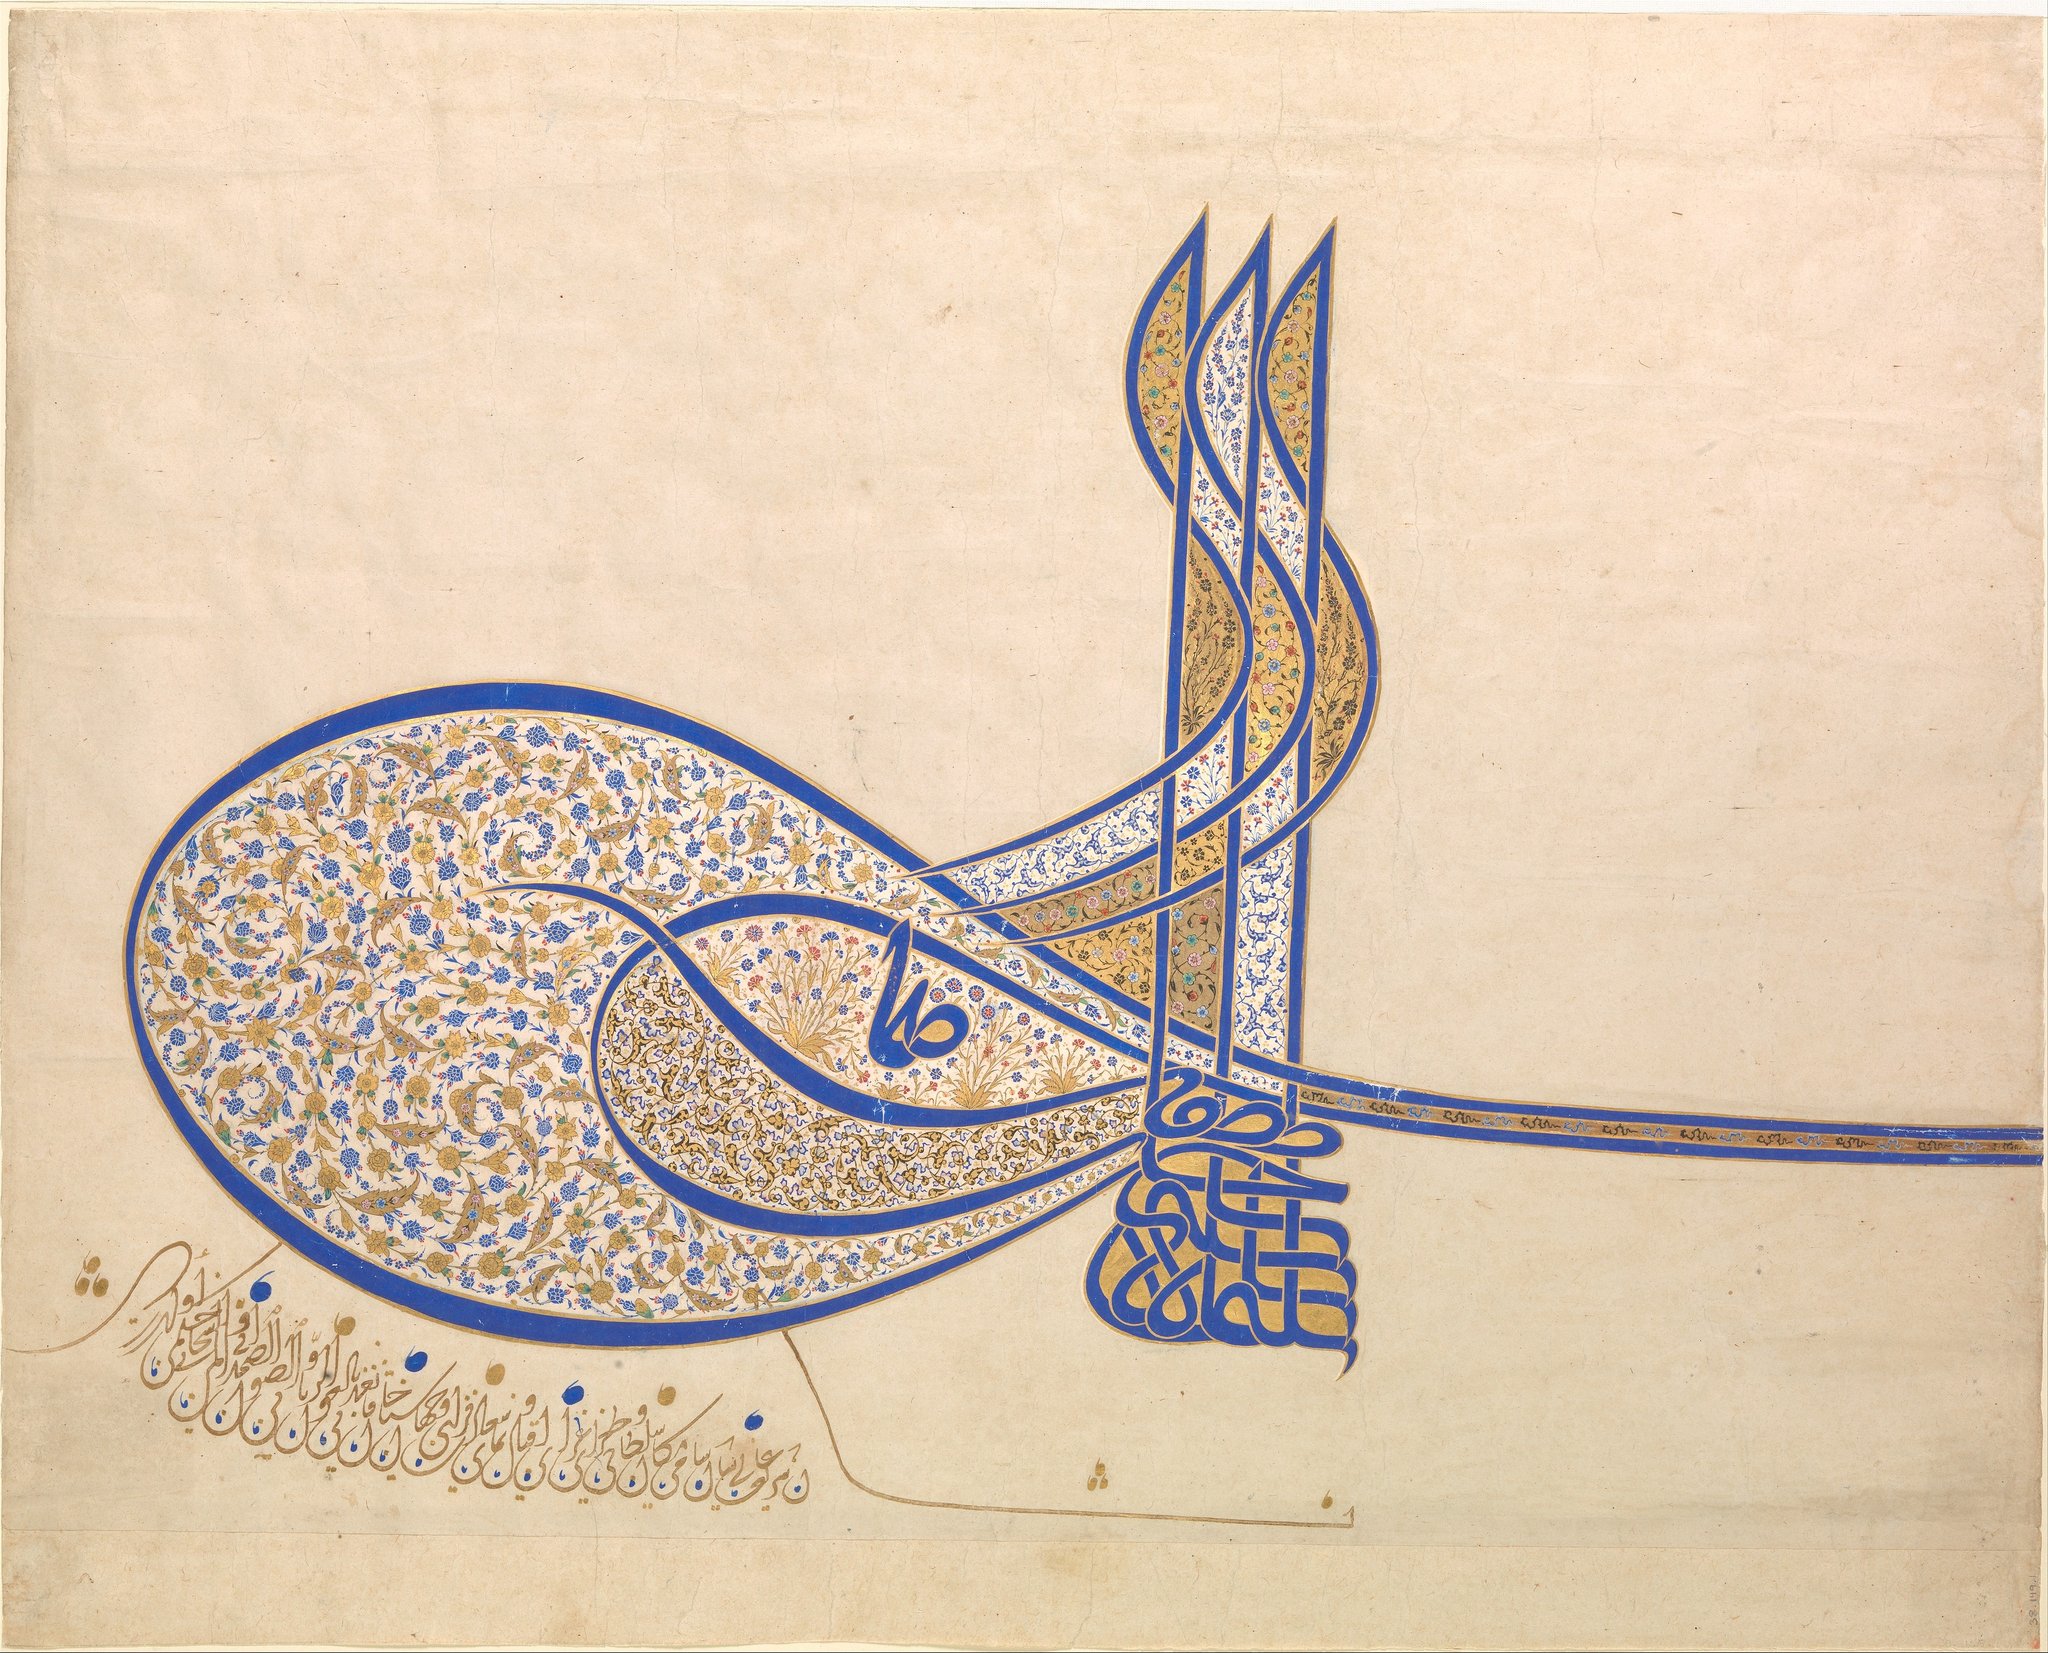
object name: tughra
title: Tughra (Insignia) of Sultan Süleiman the Magnificent (r. 1520–66)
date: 1555-1560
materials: gold, ink, paper, watercolor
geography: turkey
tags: insignia